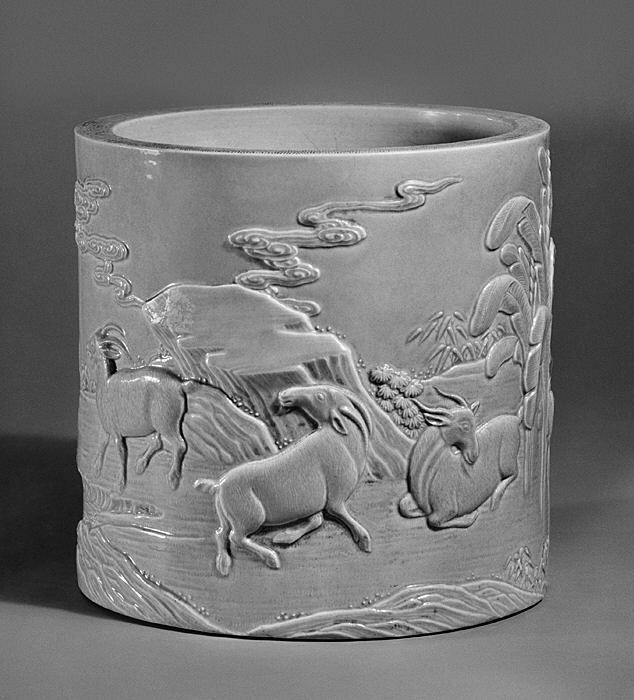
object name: brush pot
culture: chinese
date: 1767-1900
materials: porcelain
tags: goats